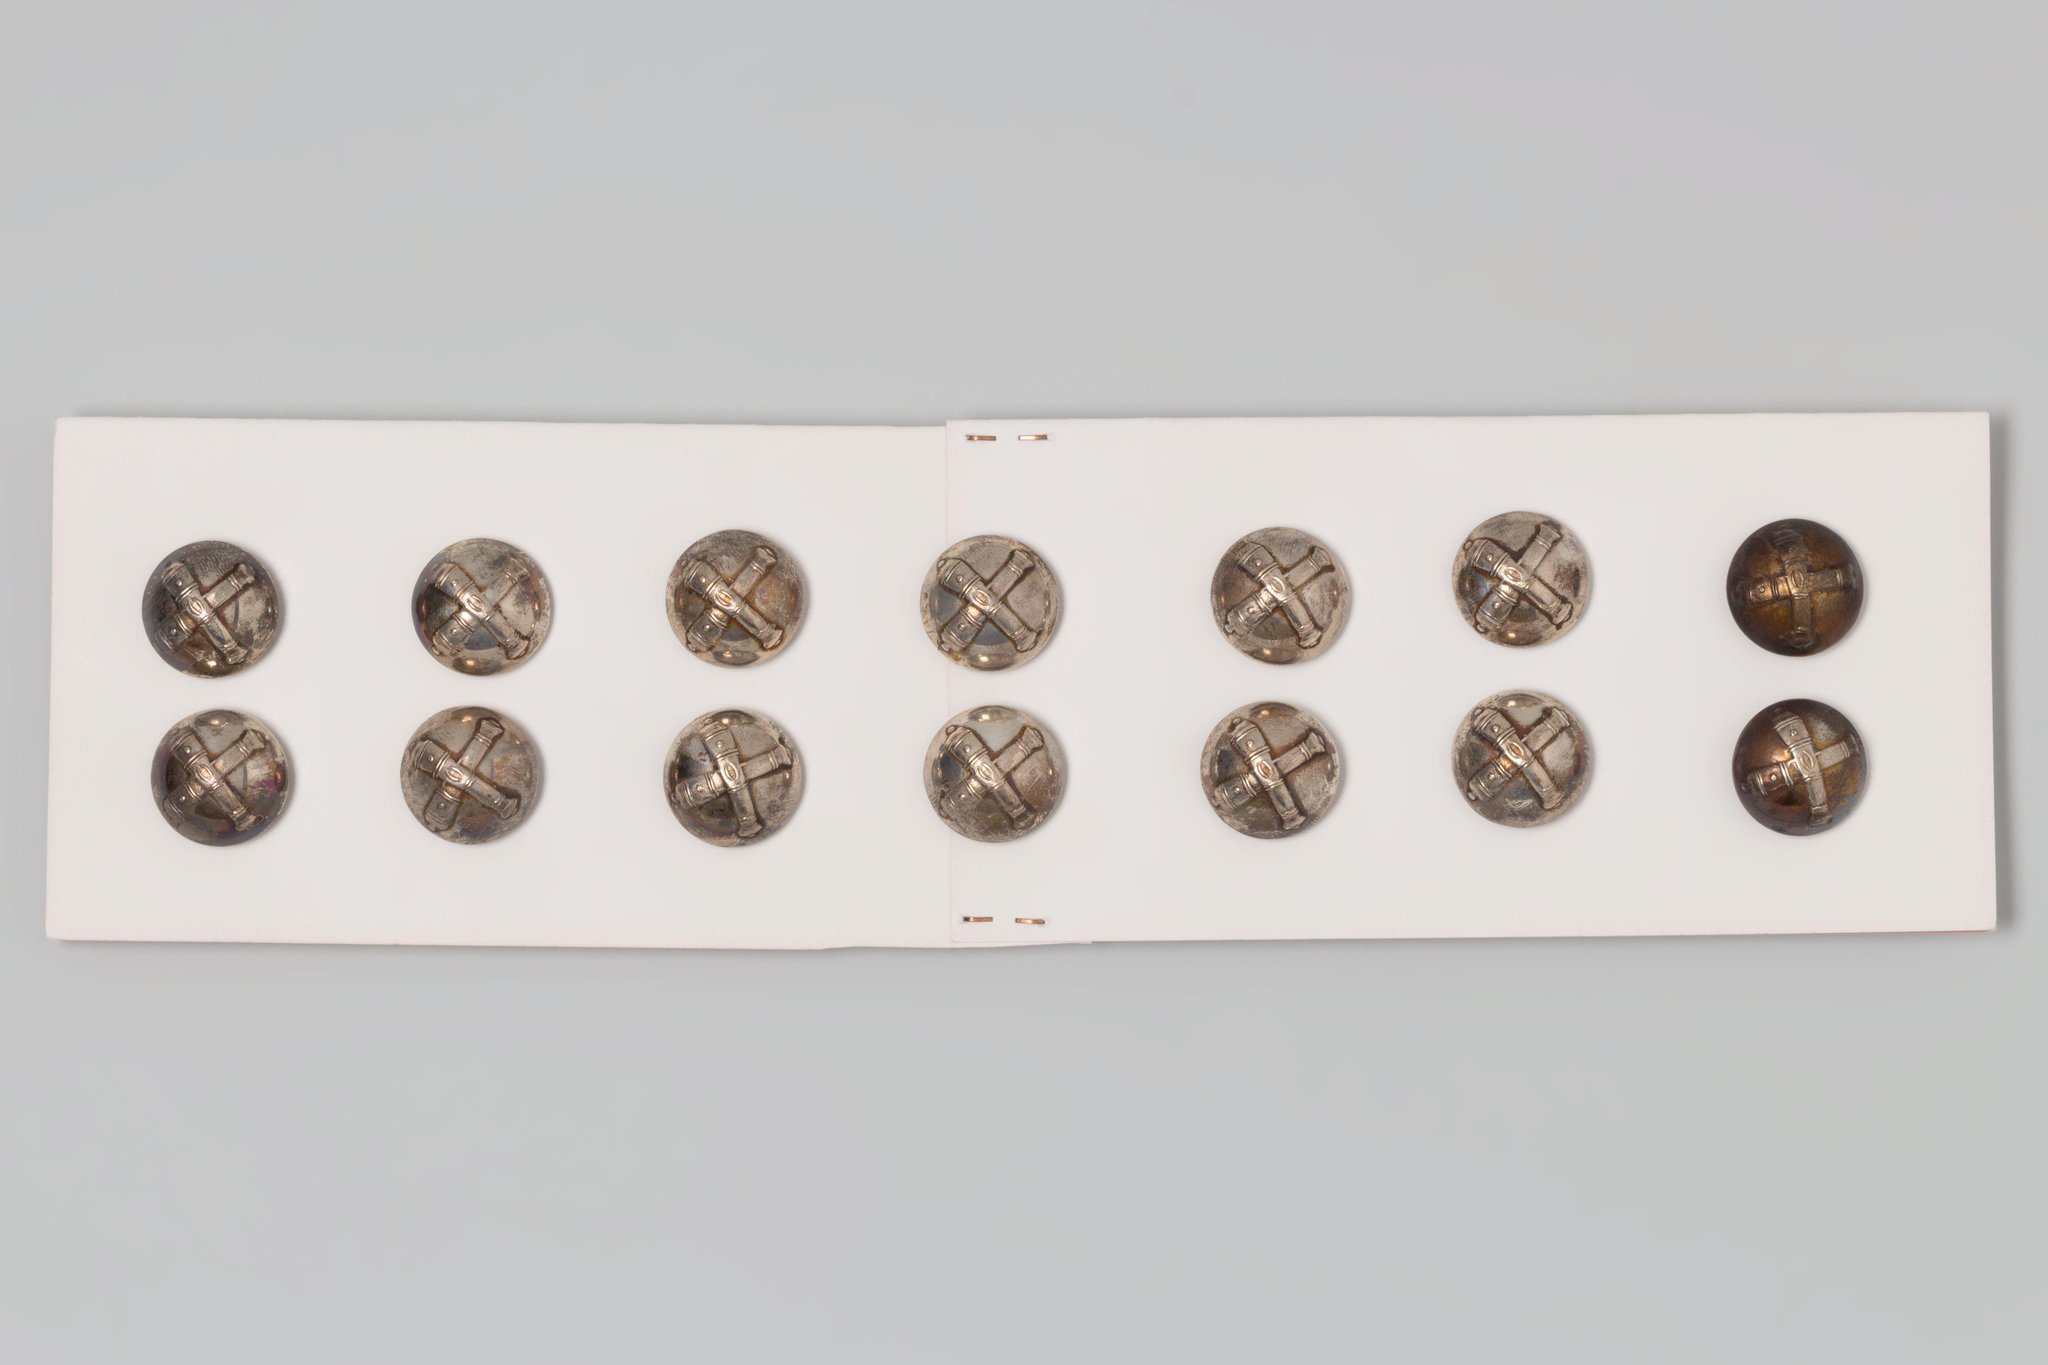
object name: menswear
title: Bolvormige knoop van verzilverd koper, waarop twee gekruiste kanonnen in reliëf; onderdeel van een artillerie-uniform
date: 1885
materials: copper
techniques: silvering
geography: the hague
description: Geborgen in een doos bij een sjerp; notitie in doos: "W. Six 1859-1928/14 knoopen schutterij uniform/1885".